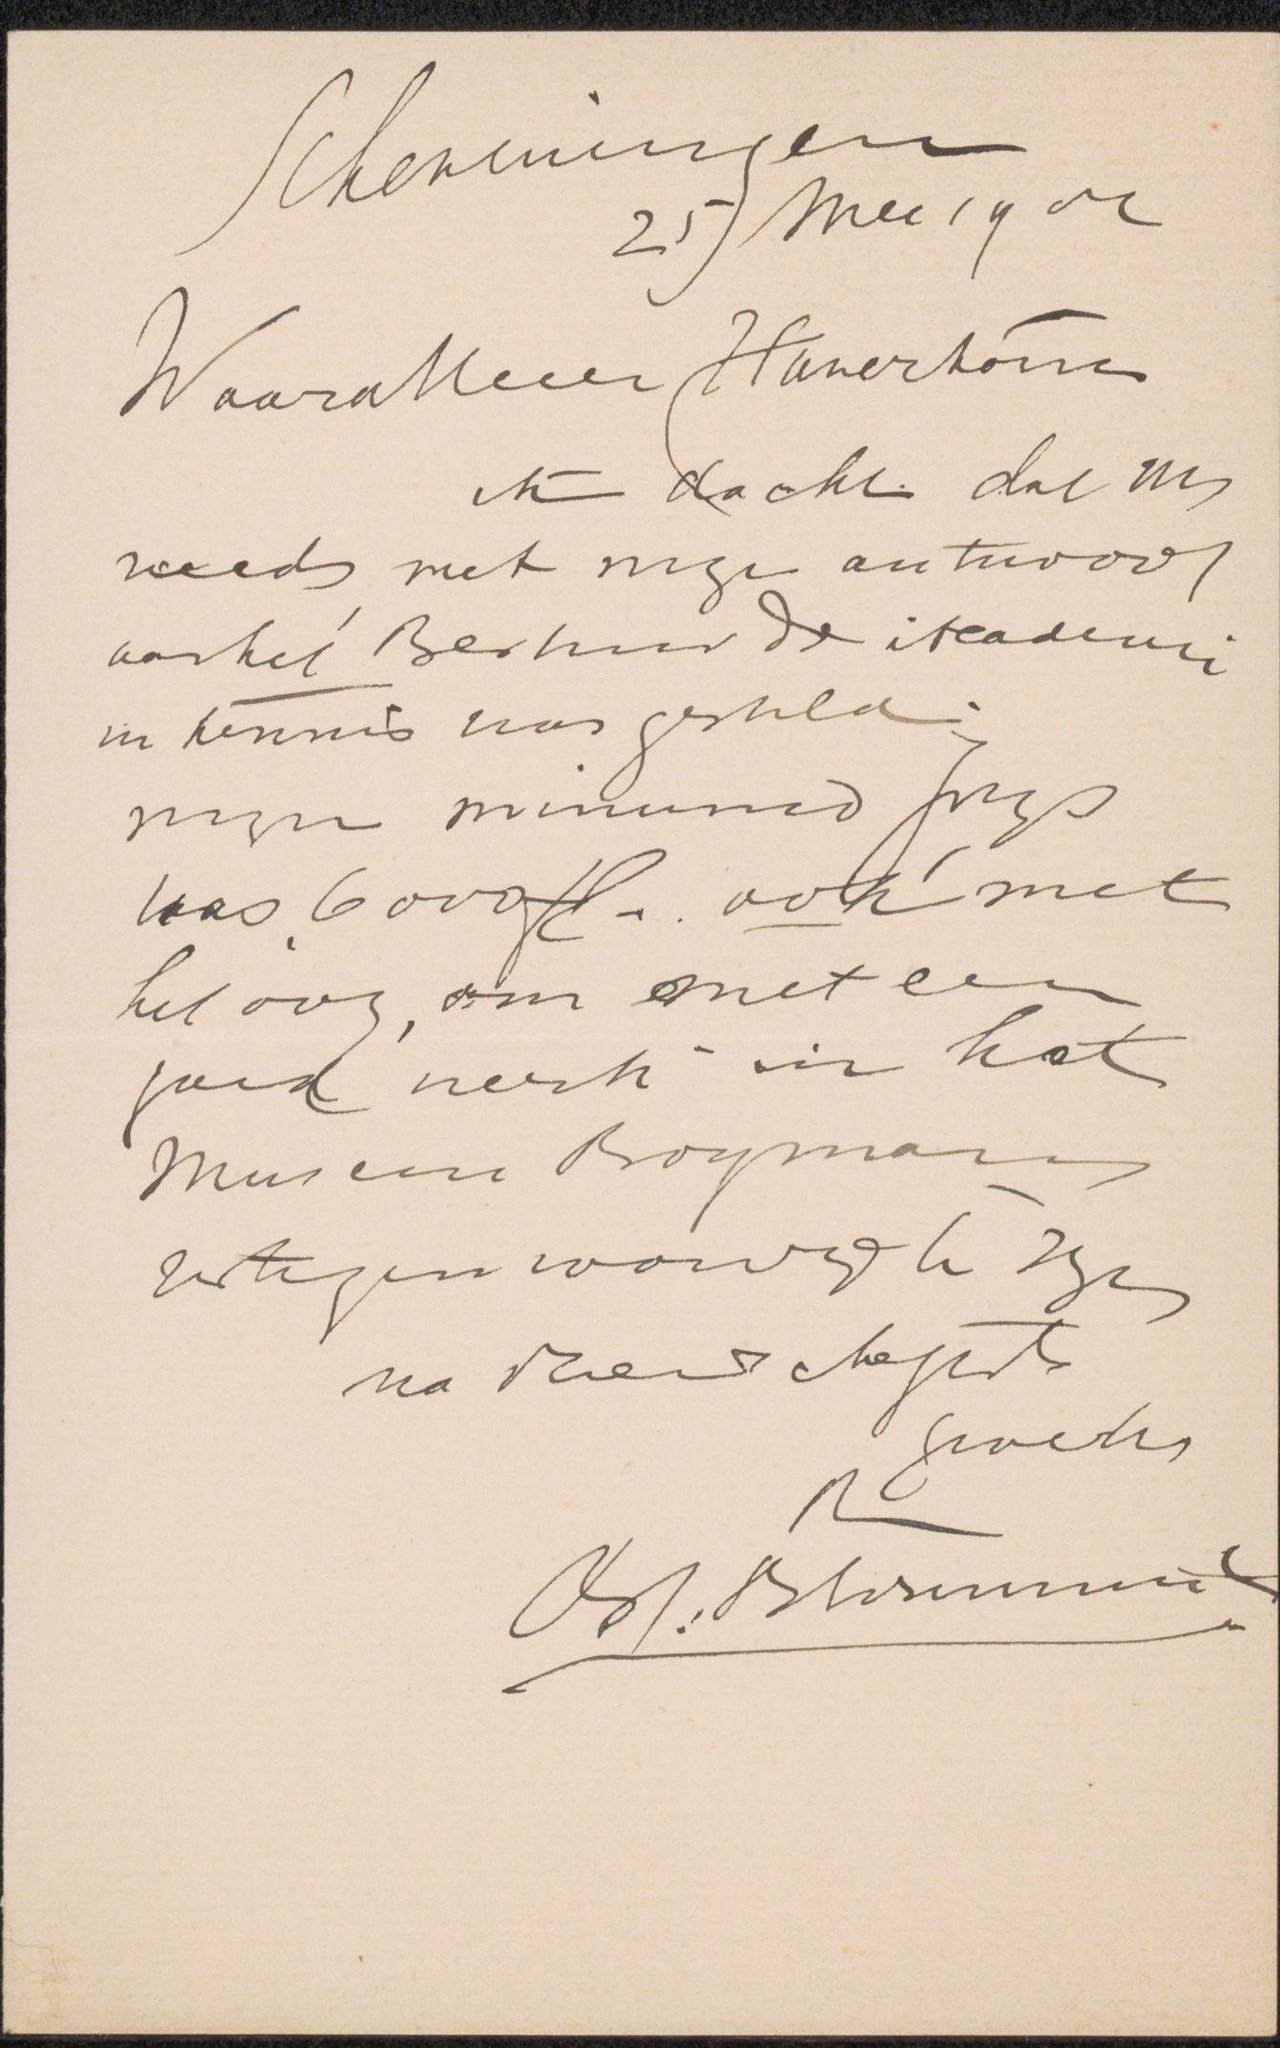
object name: letter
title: Brief aan Pieter Haverkorn van Rijsewijk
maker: bernardus johannes blommers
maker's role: draughtsman, print maker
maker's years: 1845-1914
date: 1904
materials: ink, paper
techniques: pen, writing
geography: scheveningen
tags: pieter haverkorn van rijsewijk, money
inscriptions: watermark, collector's mark: ‘RPK’